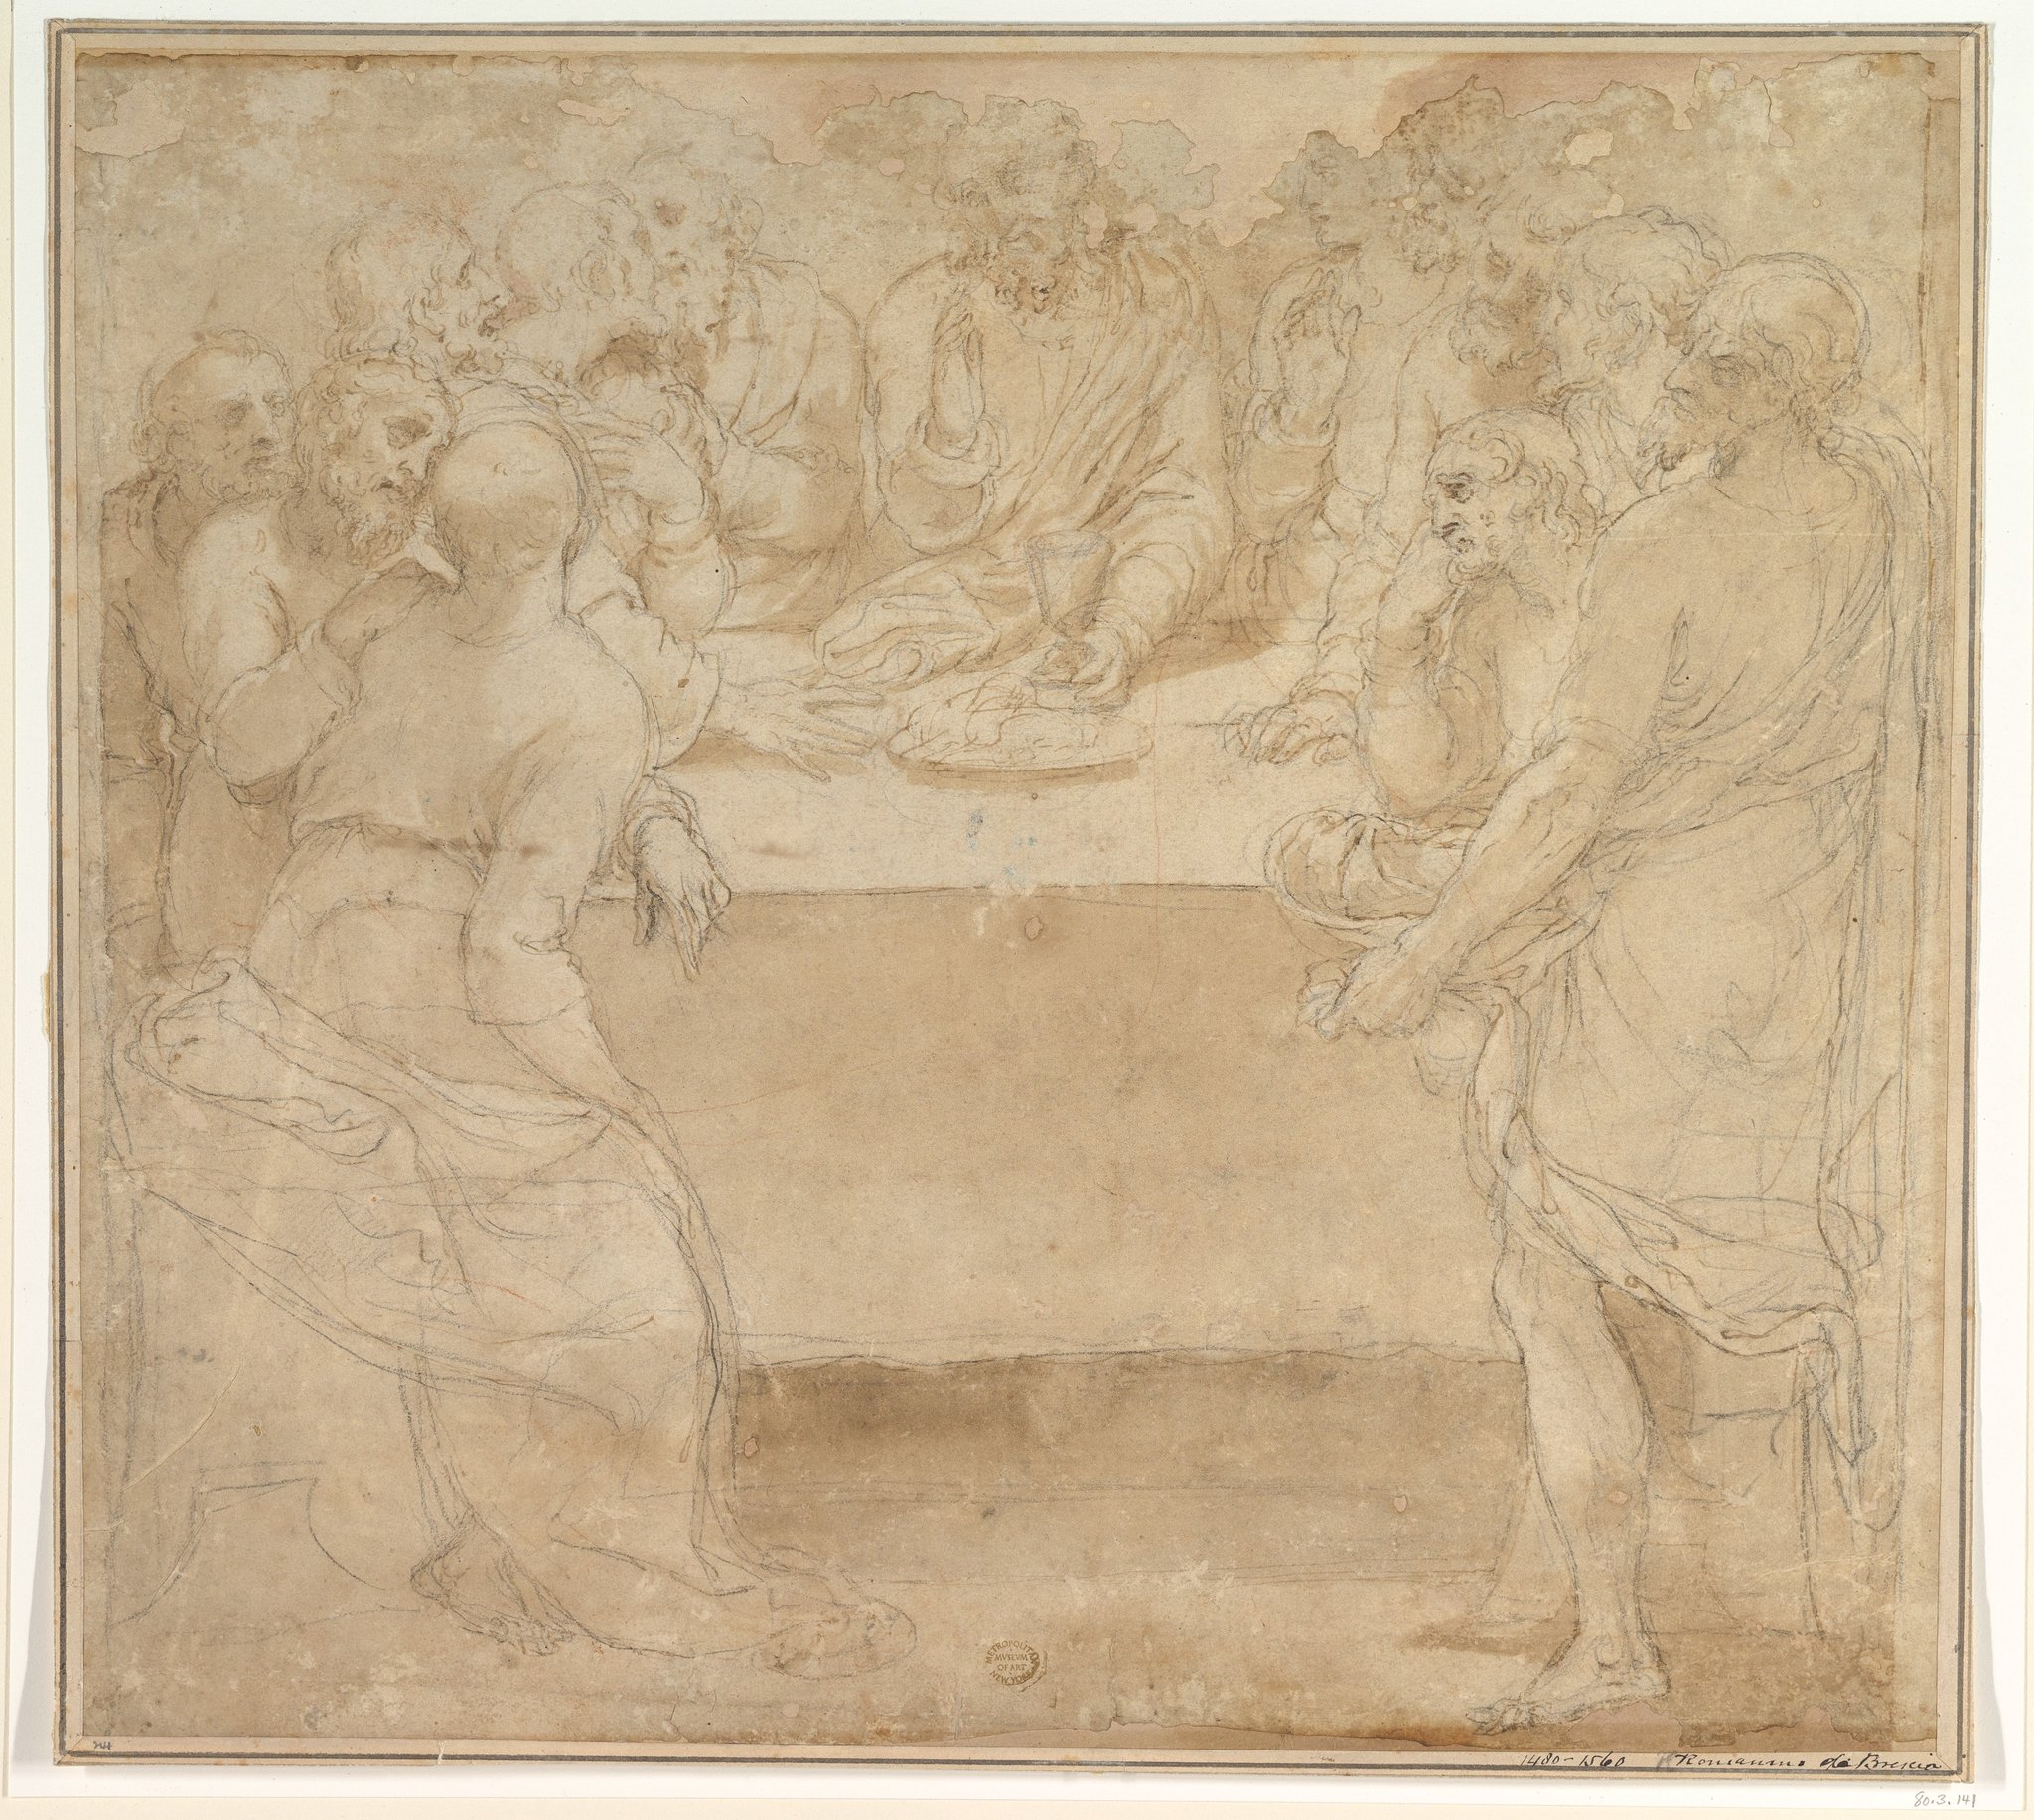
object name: drawing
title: The Last Supper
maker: anonymous, italian, mid-16th century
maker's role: artist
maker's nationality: italian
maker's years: 1520-1580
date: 1550-1580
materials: chalk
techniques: brush, wash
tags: men,christ,last supper